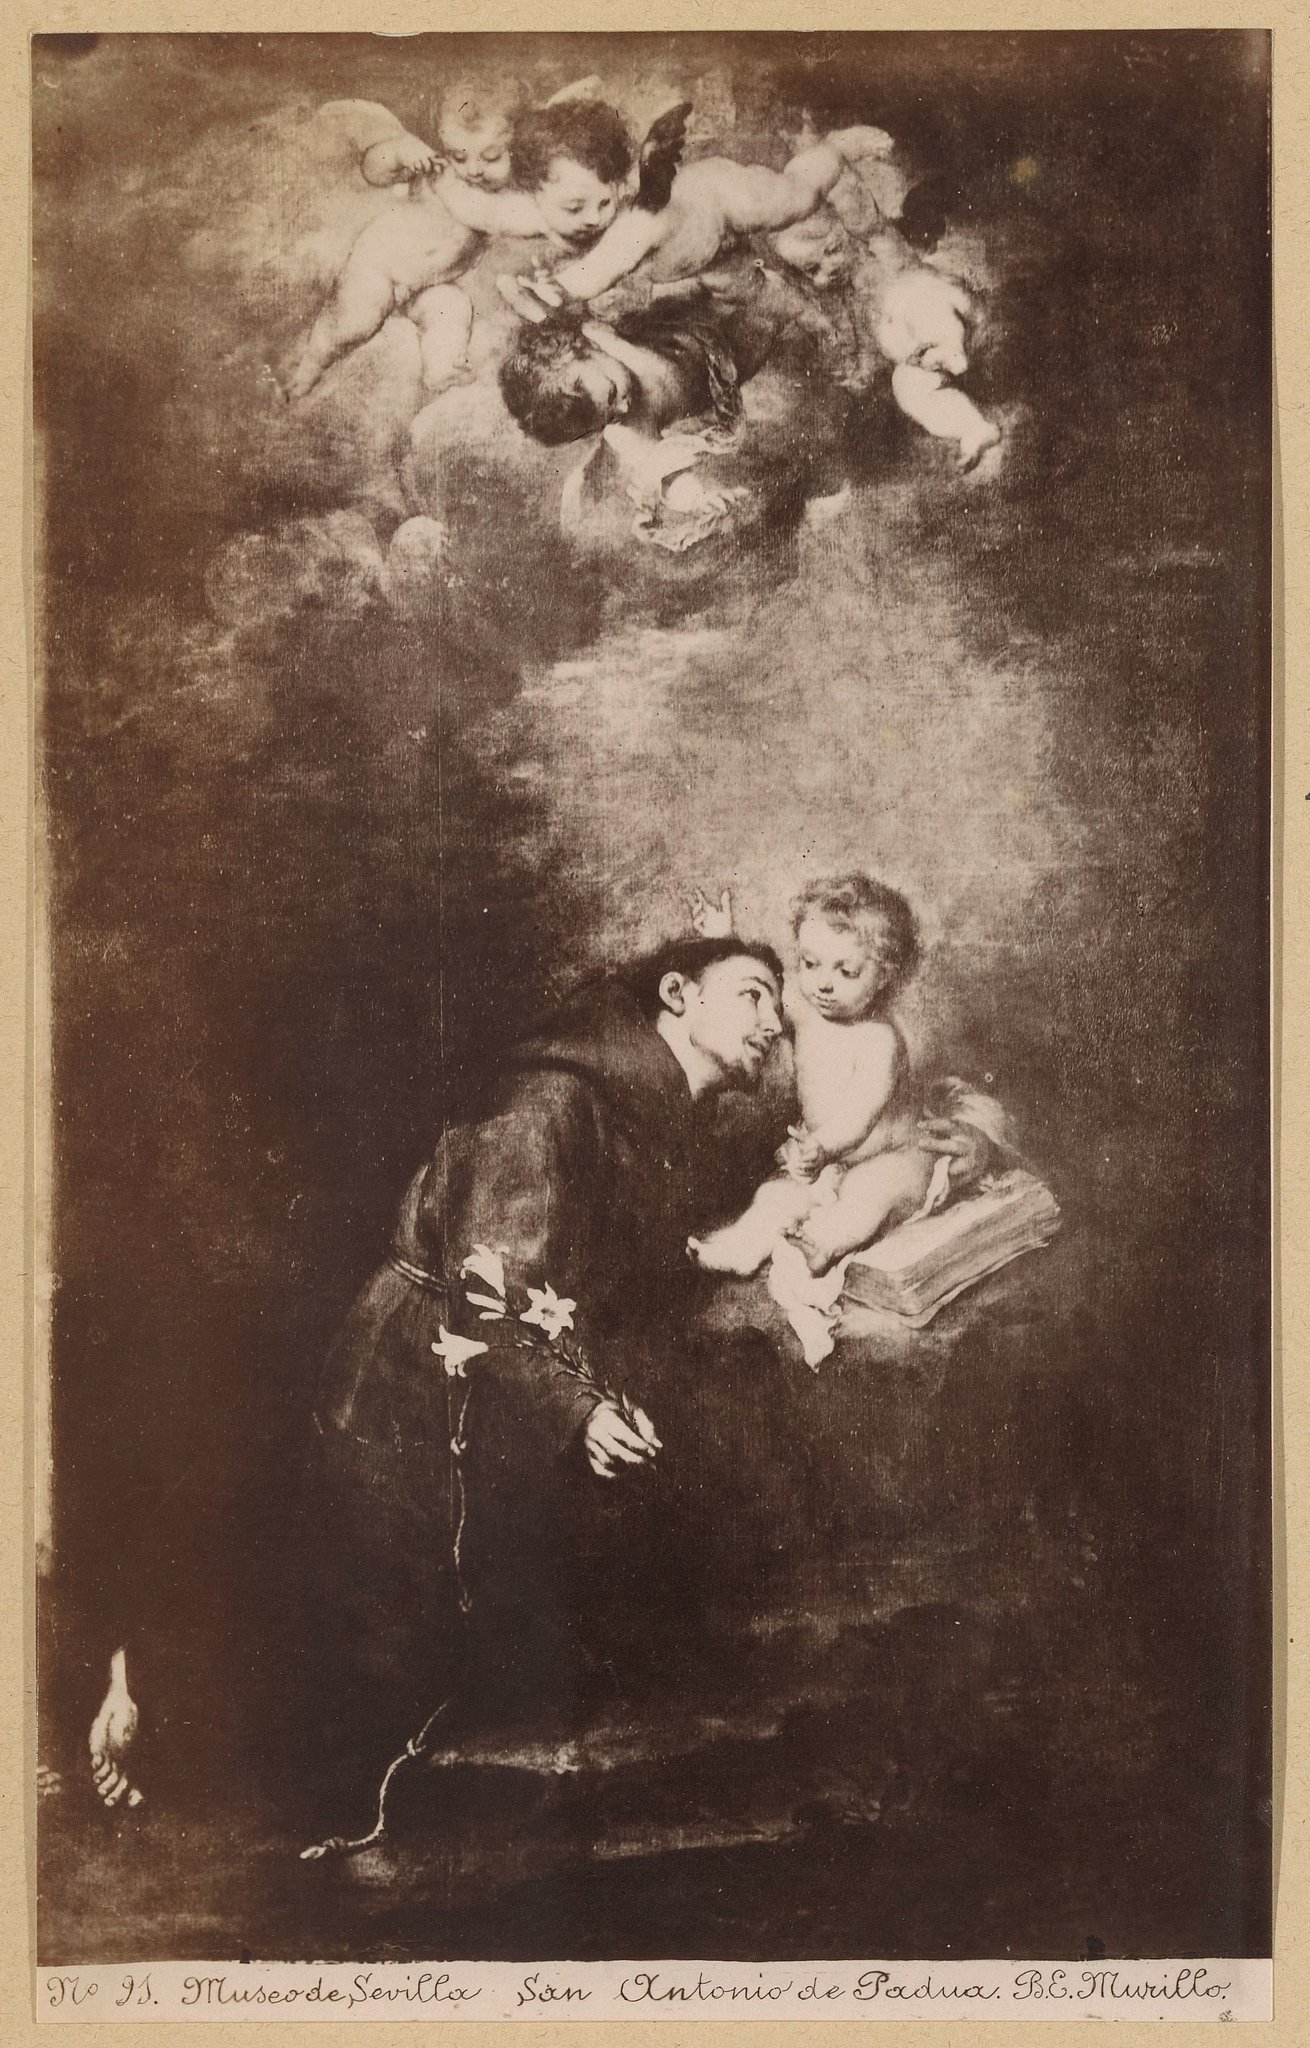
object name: reproduction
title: Fotoreproductie van een schilderij van de heilige Antonius van Padua met het Kind van Bartolomé Murillo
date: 1880-1905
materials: paper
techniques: albumen print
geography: sevilla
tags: clergyman, visions of st. antony of padua, sevilla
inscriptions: number: ‘No 91. [?]’